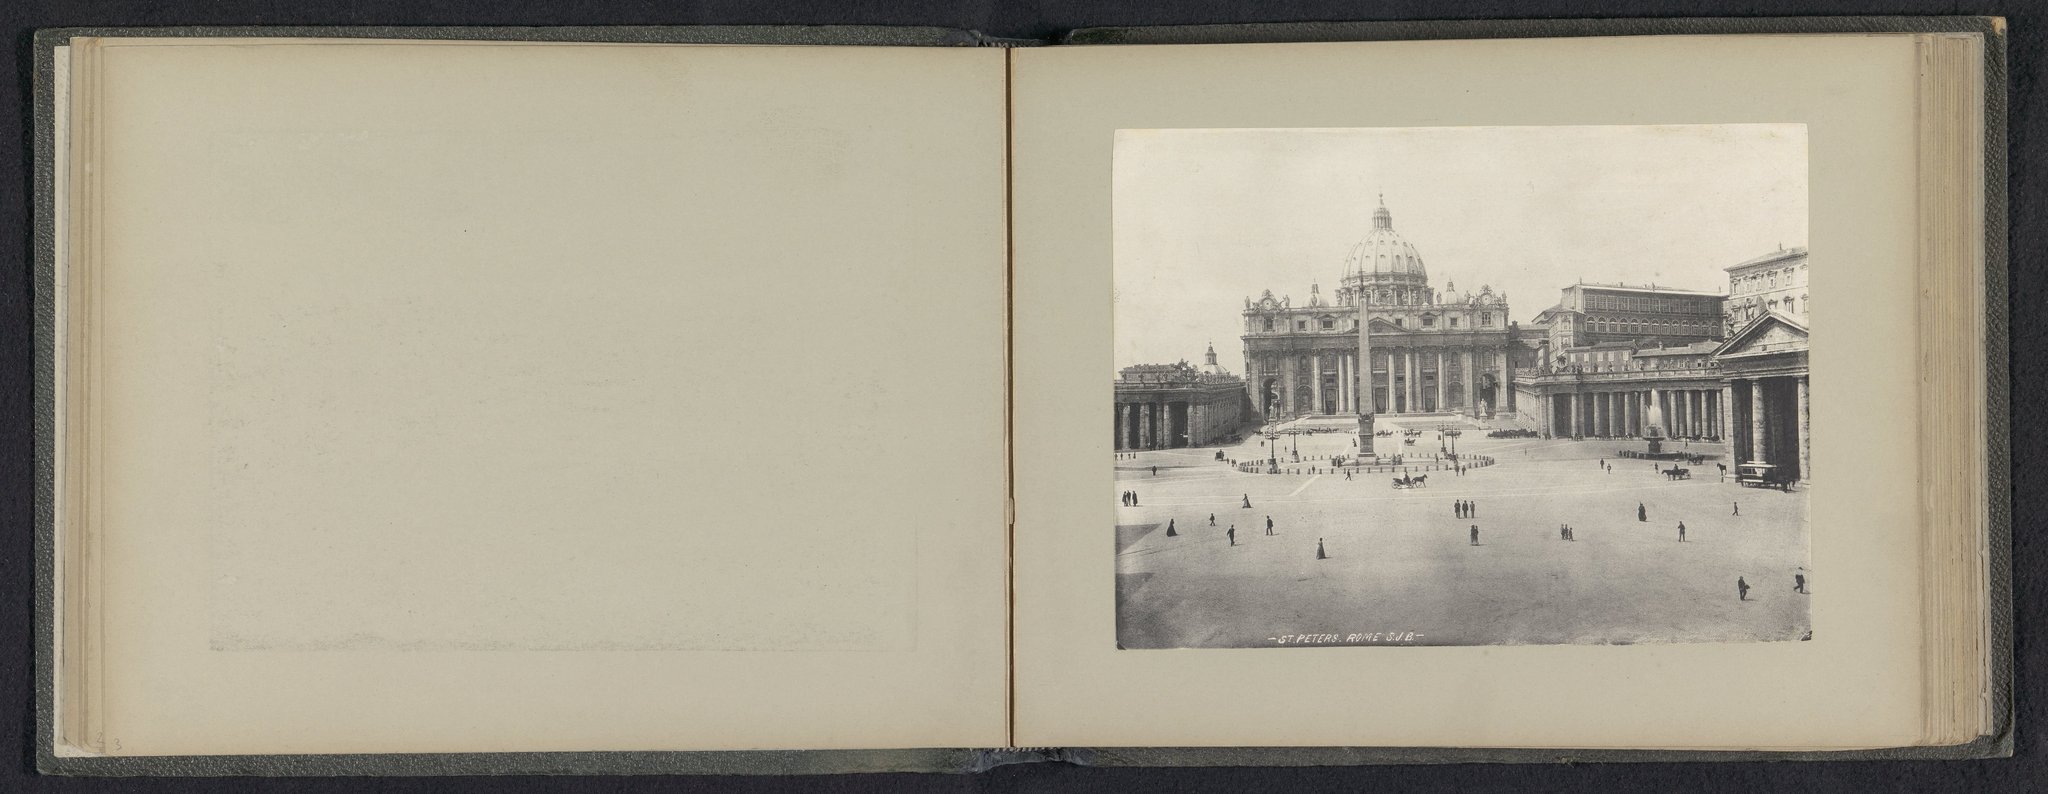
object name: page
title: St. Peters. Rome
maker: samuel j. beckett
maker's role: fotograaf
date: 1890-1900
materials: paper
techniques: photograph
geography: vatican city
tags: square, place, circus, etc., church (exterior), façade (of house or building)